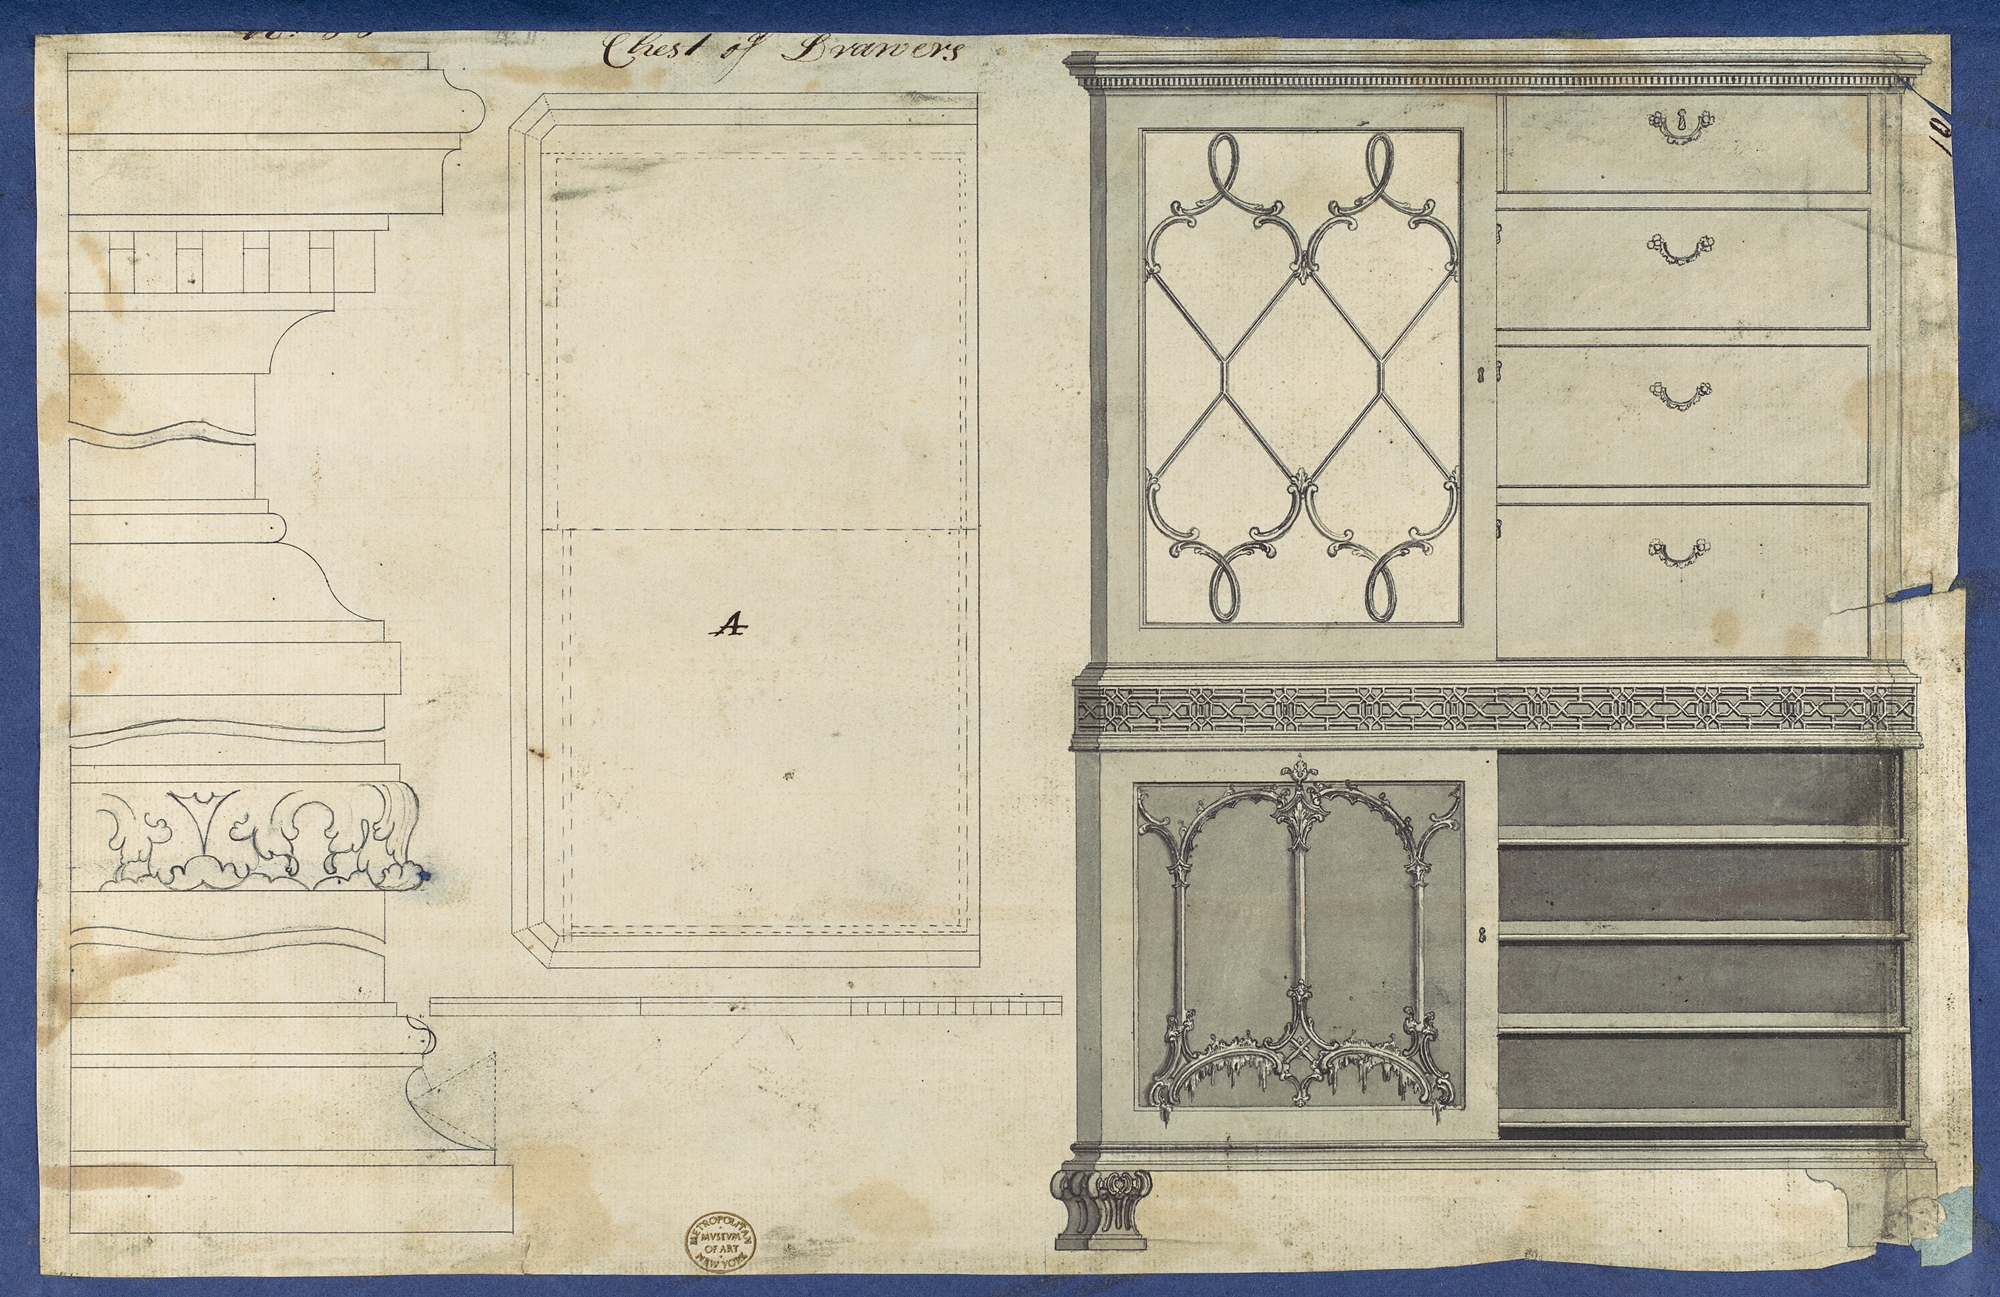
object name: drawing ornament architecture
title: Chest of Drawers, from Chippendale Drawings, Vol. II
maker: thomas chippendale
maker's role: artist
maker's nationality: british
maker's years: 1718-1779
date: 1753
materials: ink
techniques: wash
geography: london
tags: chests